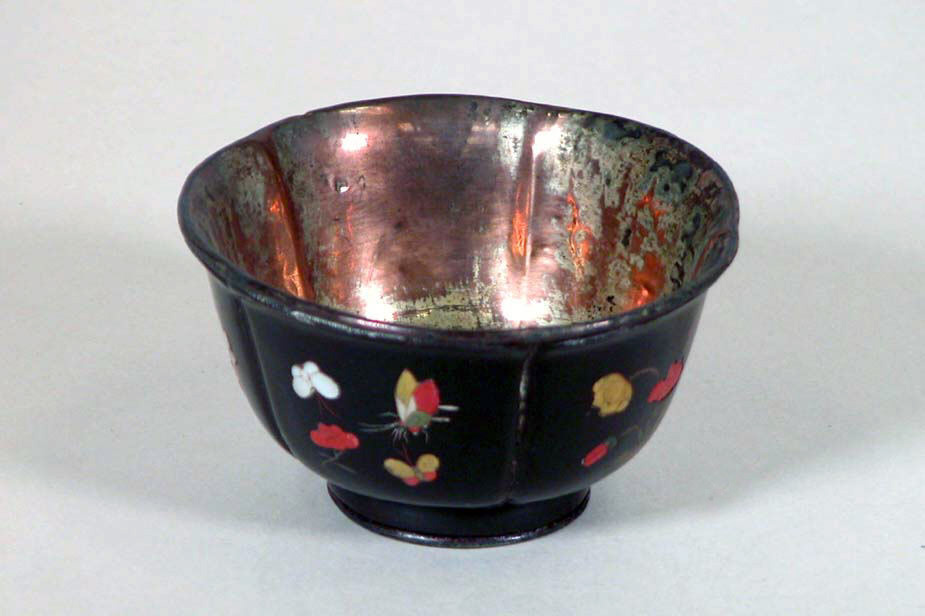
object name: bowl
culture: chinese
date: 1701-1800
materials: lacquer